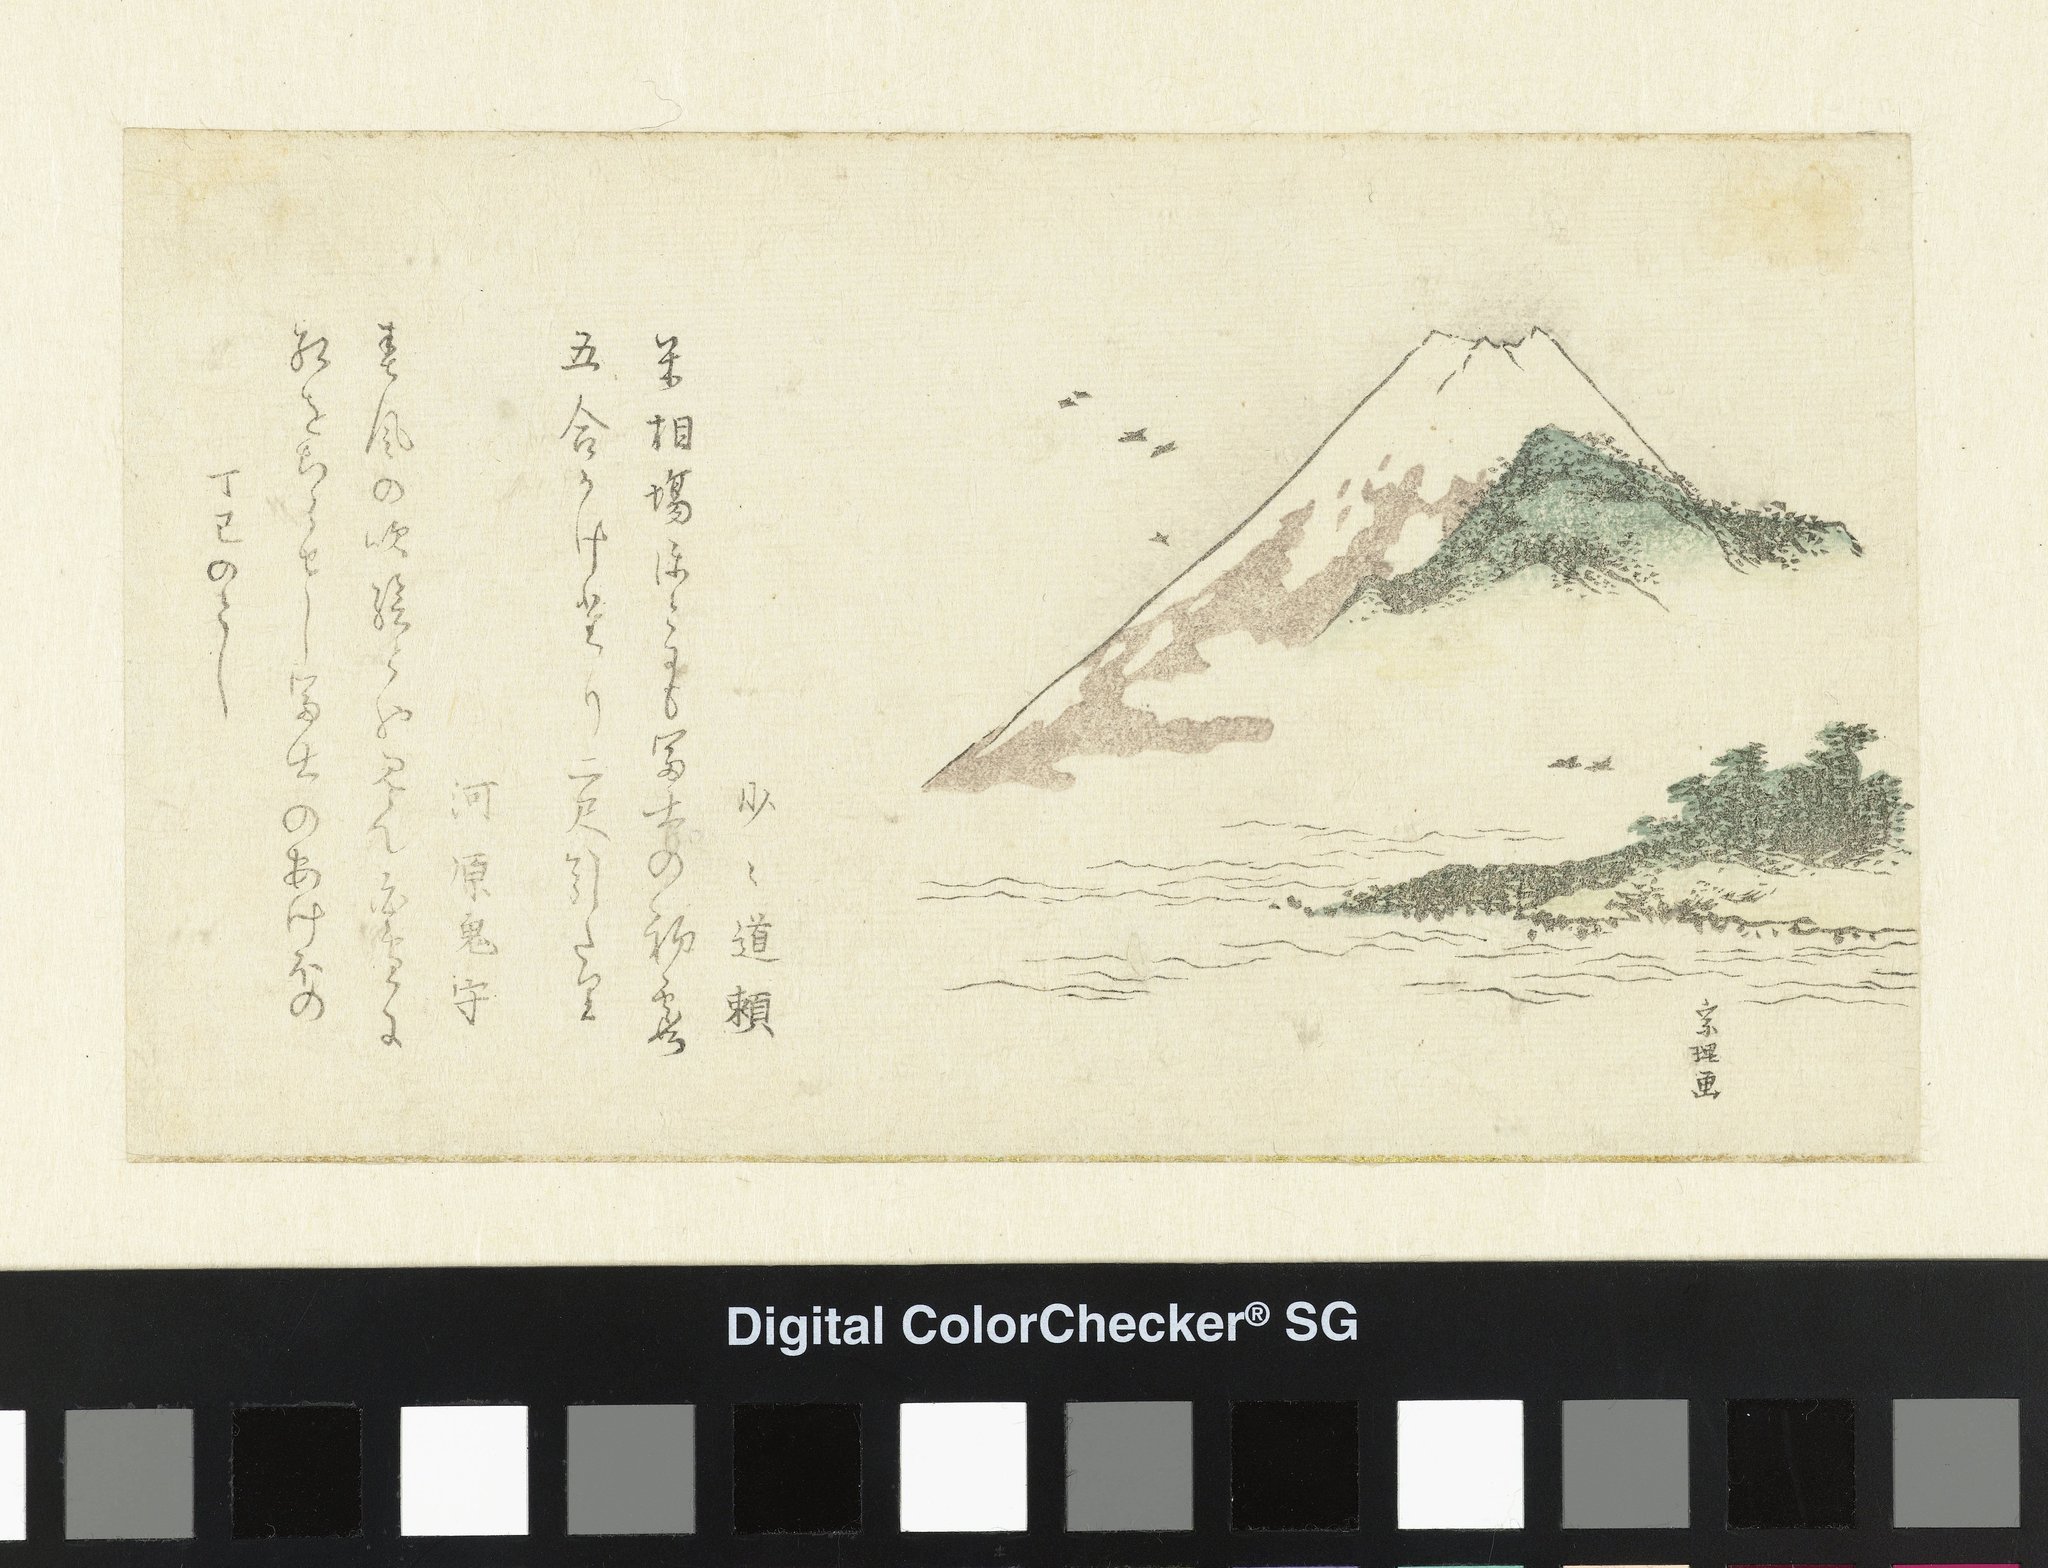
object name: print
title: Gezicht op de berg Fuji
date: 1797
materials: paper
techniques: blind stamped, woodcut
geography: japan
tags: mountains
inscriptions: collector's mark, verso, stamped: Lugt 2760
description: Een surimono is een luxe uitgevoerde prent waarop beeld met één of meerdere gedichten gecombineerd is. Bij het drukken van een surimono werd vaak gebruik gemaakt van dikker papier, blinddruk en metaal pigmenten, zoals koper- en zilverpoeder. De prenten werden vaak in opdracht van dichters gemaakt en als exclusief geschenk aan vrienden en relaties gegeven.